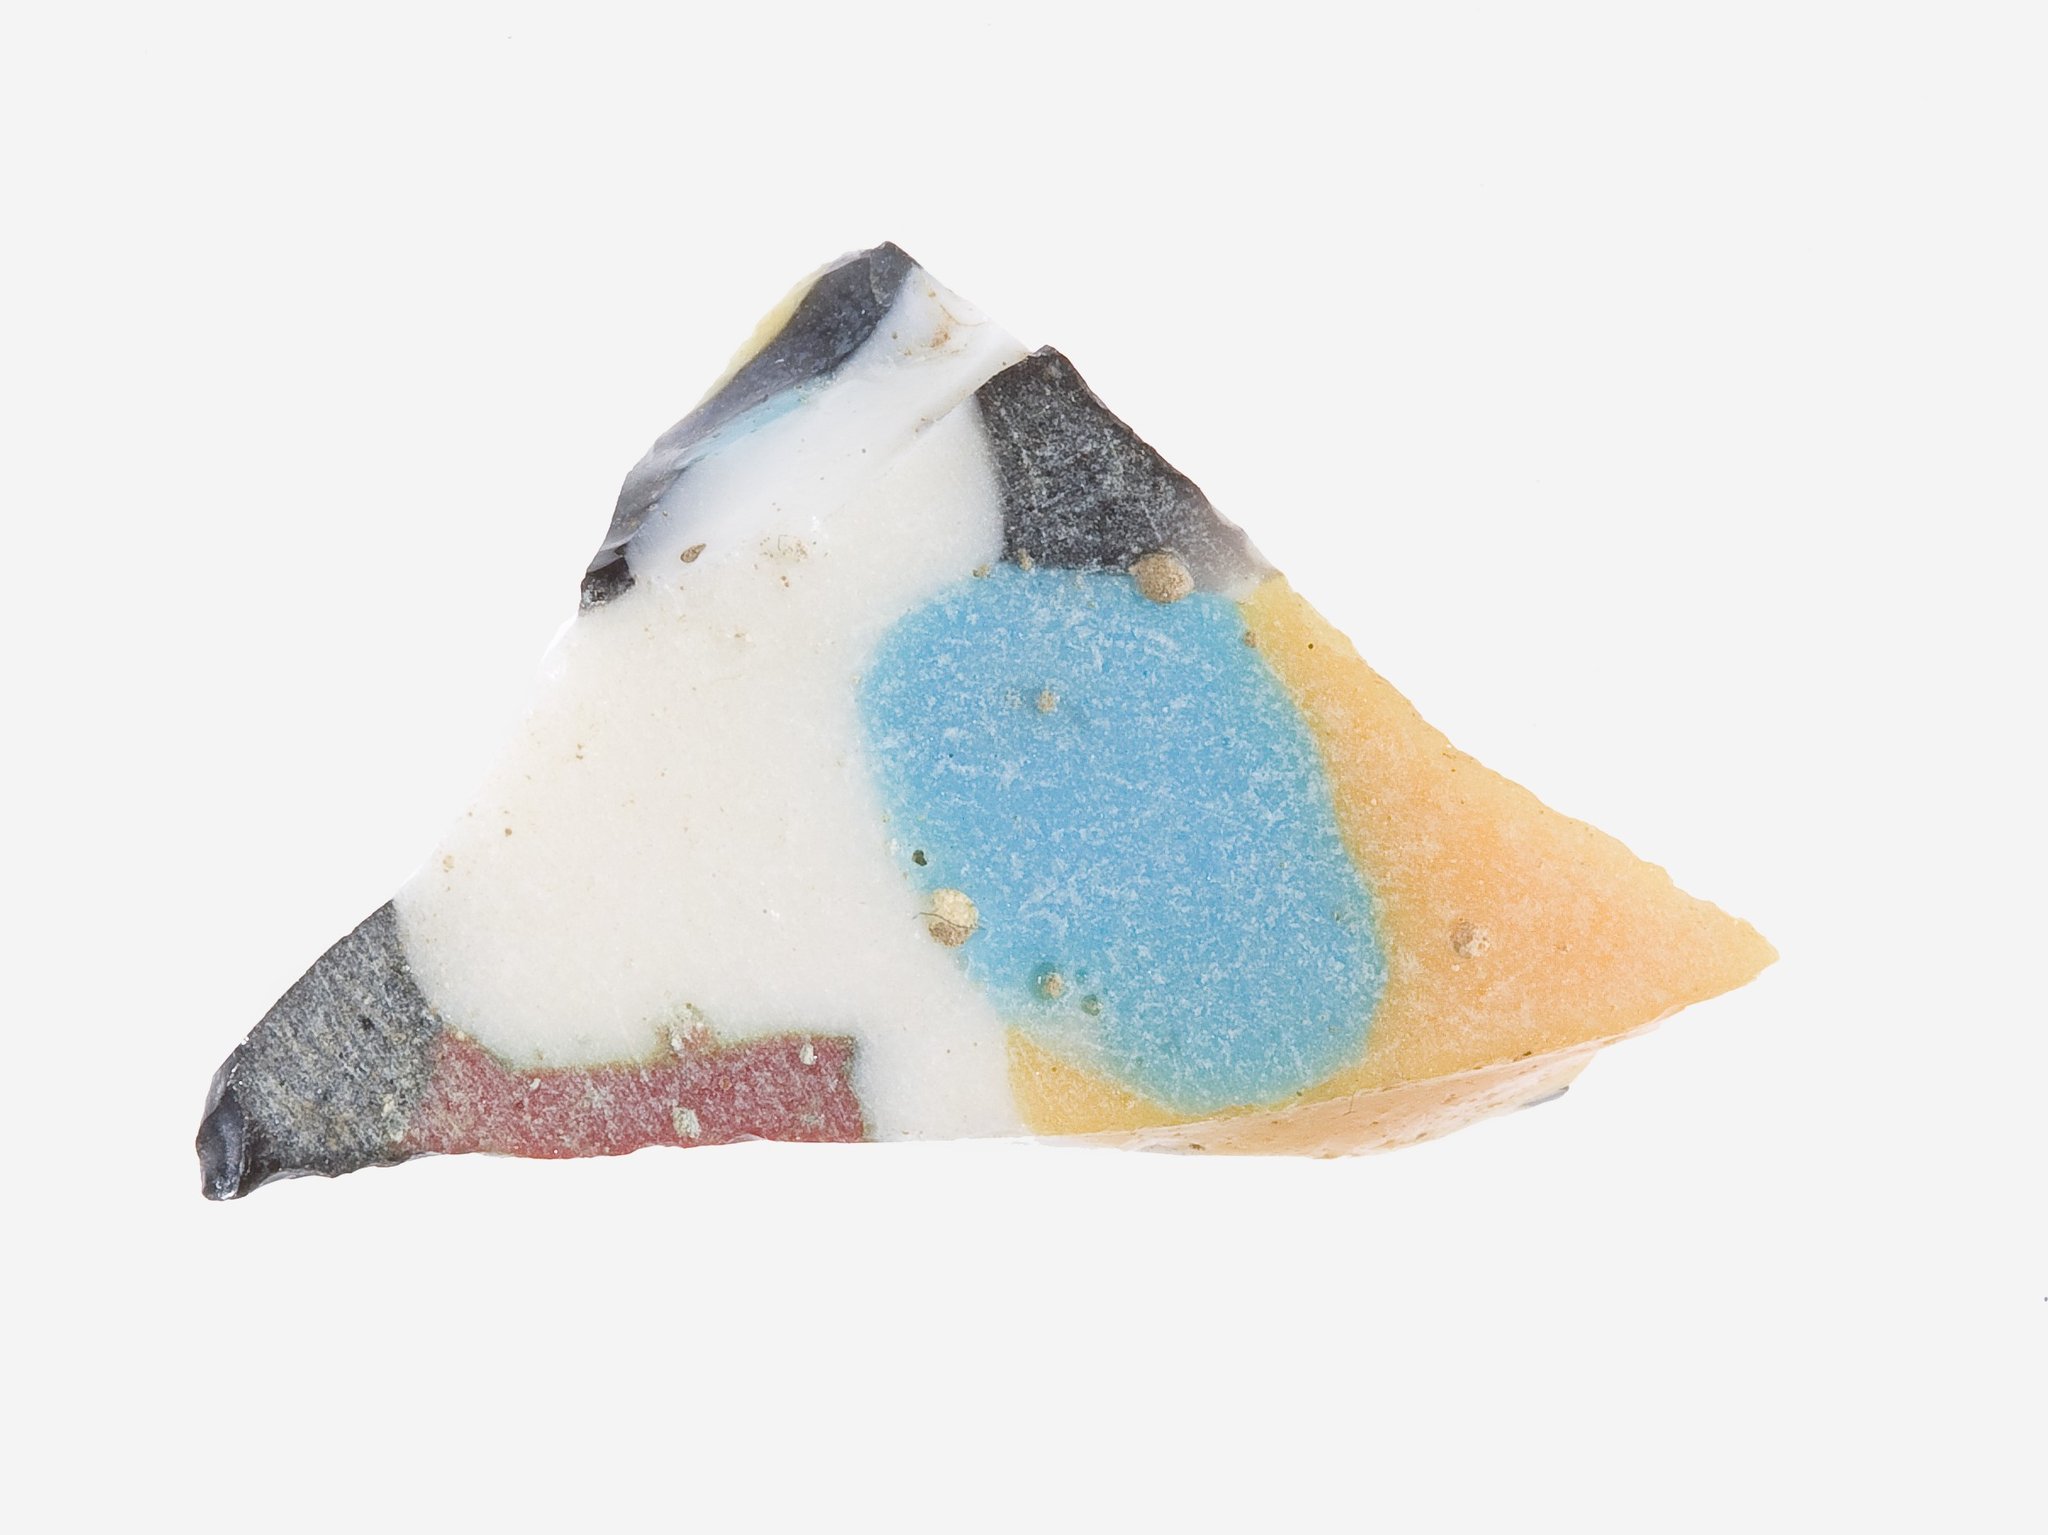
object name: vessel fragment, mosaic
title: Base Fragment of a Dish of Polychrome Mosaic Glass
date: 1390-1352 BCE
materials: glass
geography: egypt